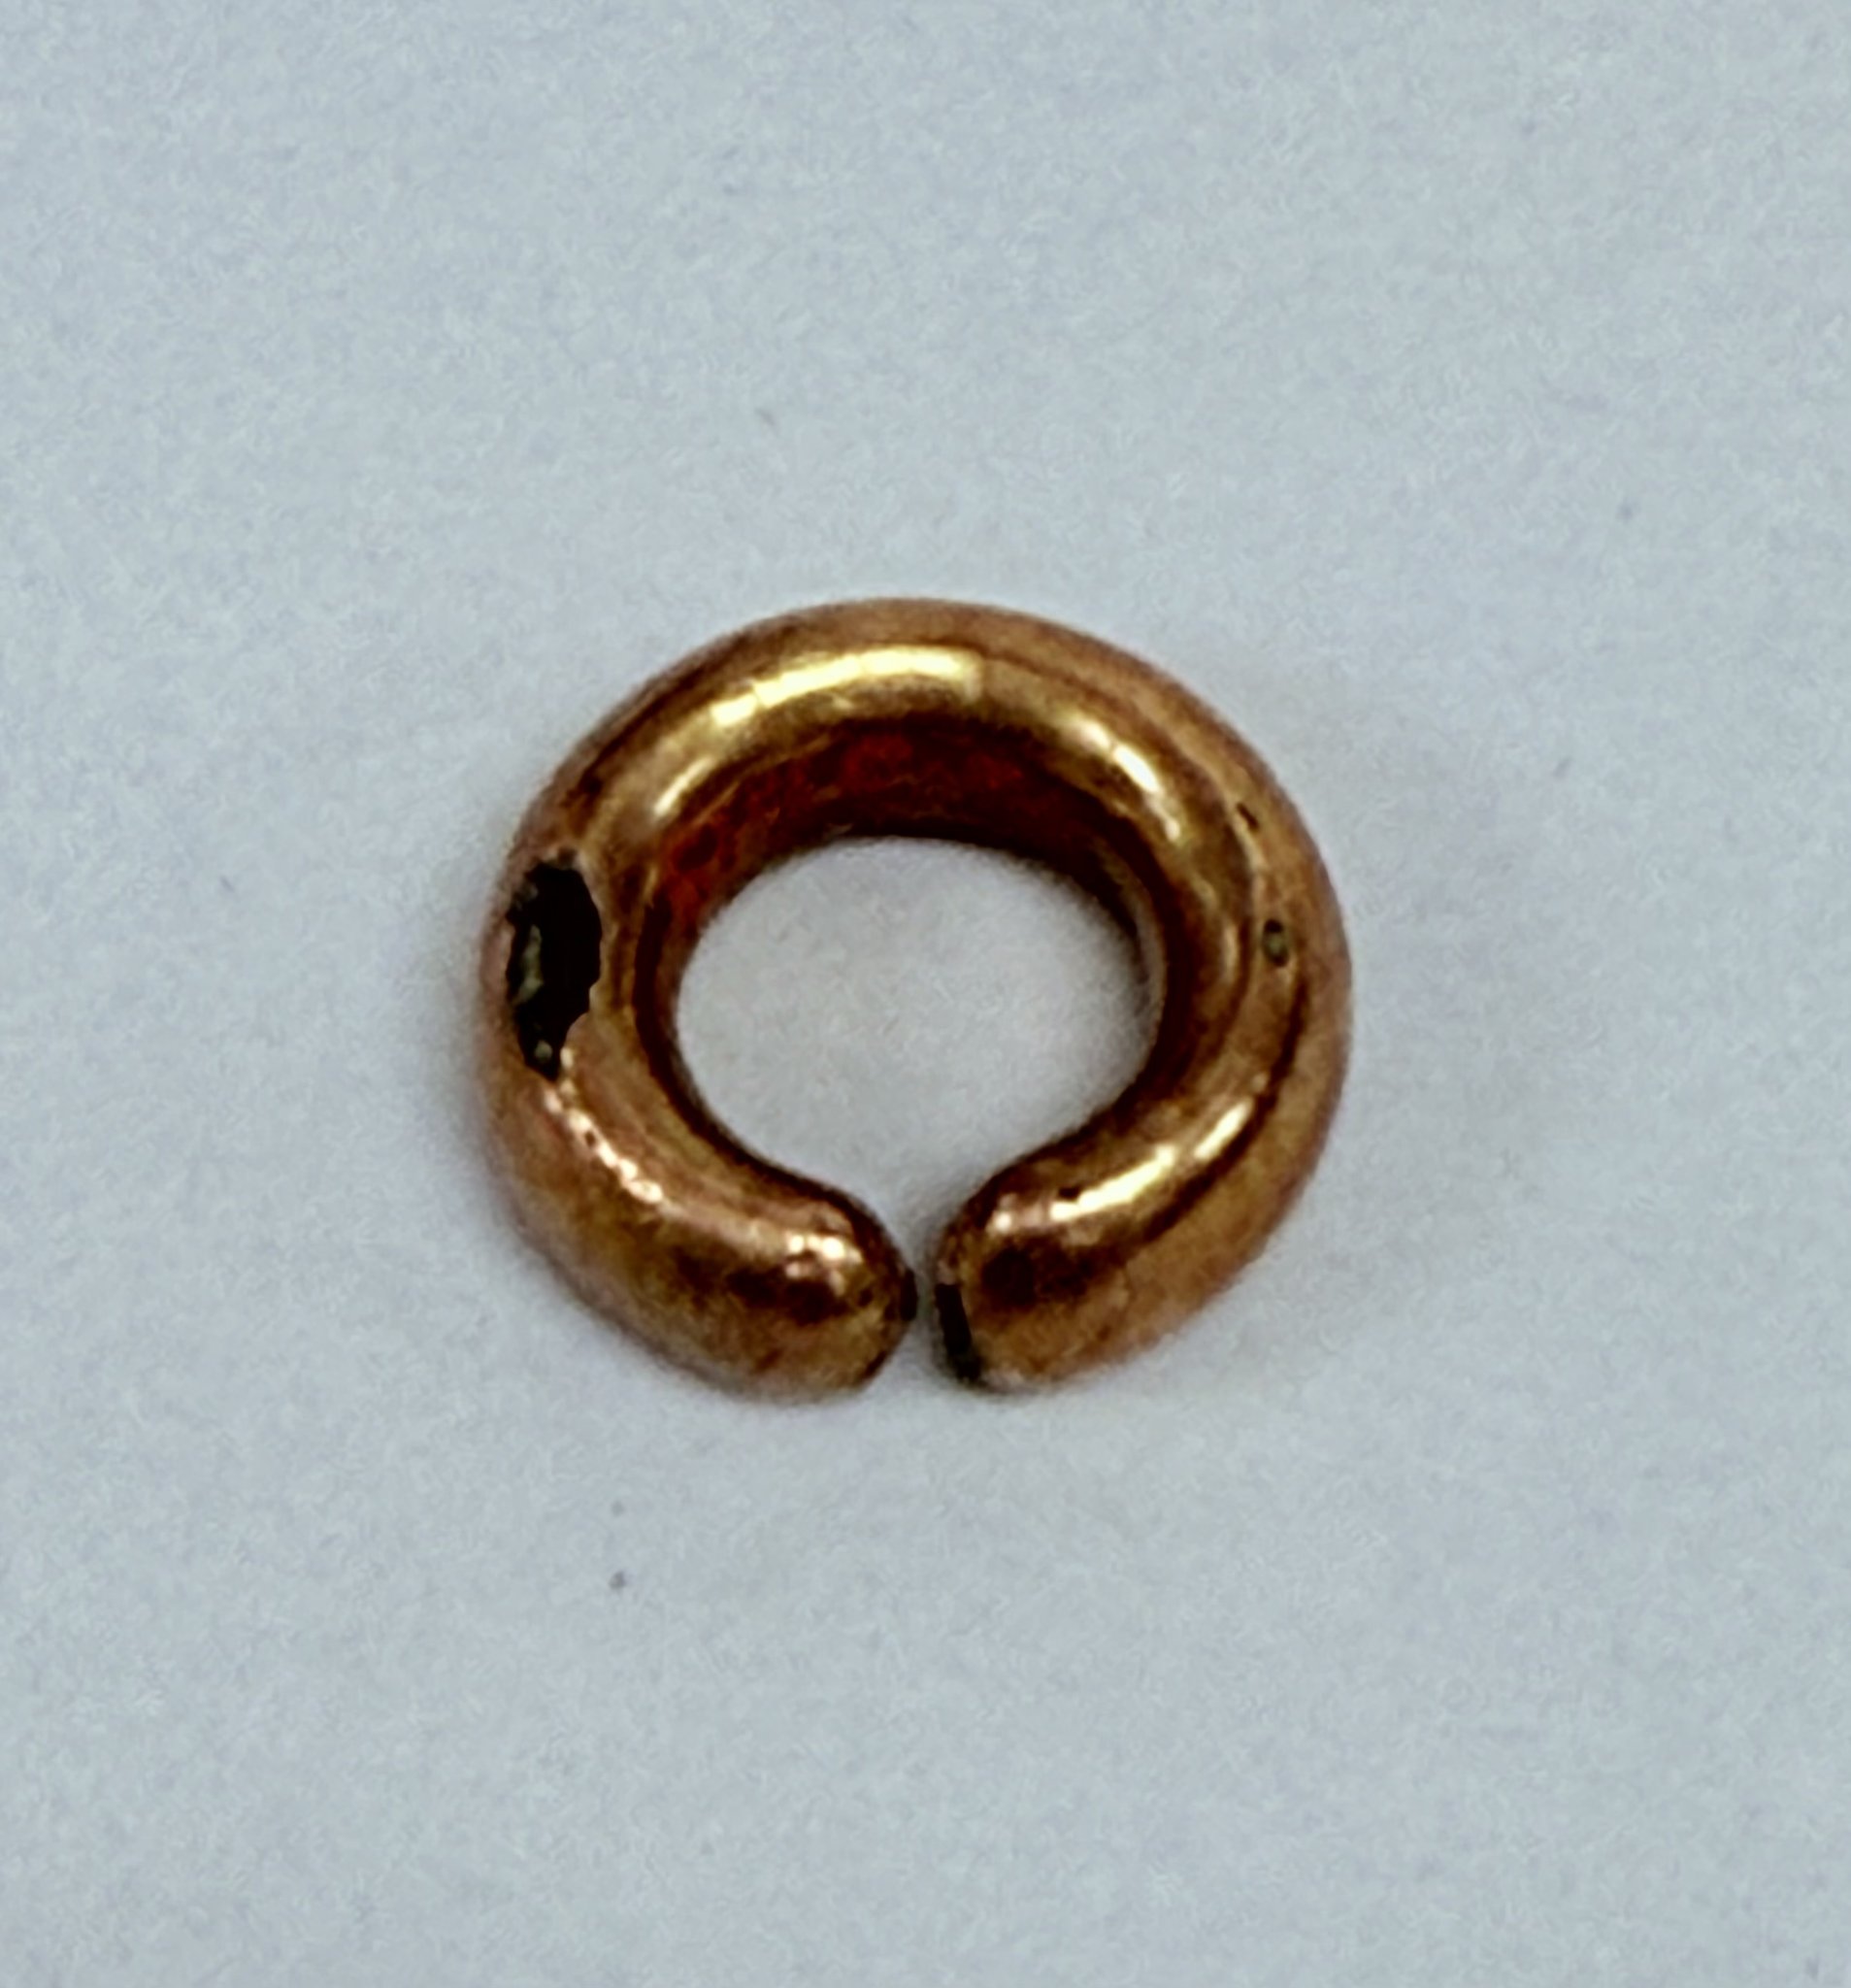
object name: earring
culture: japanese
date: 601-700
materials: gold